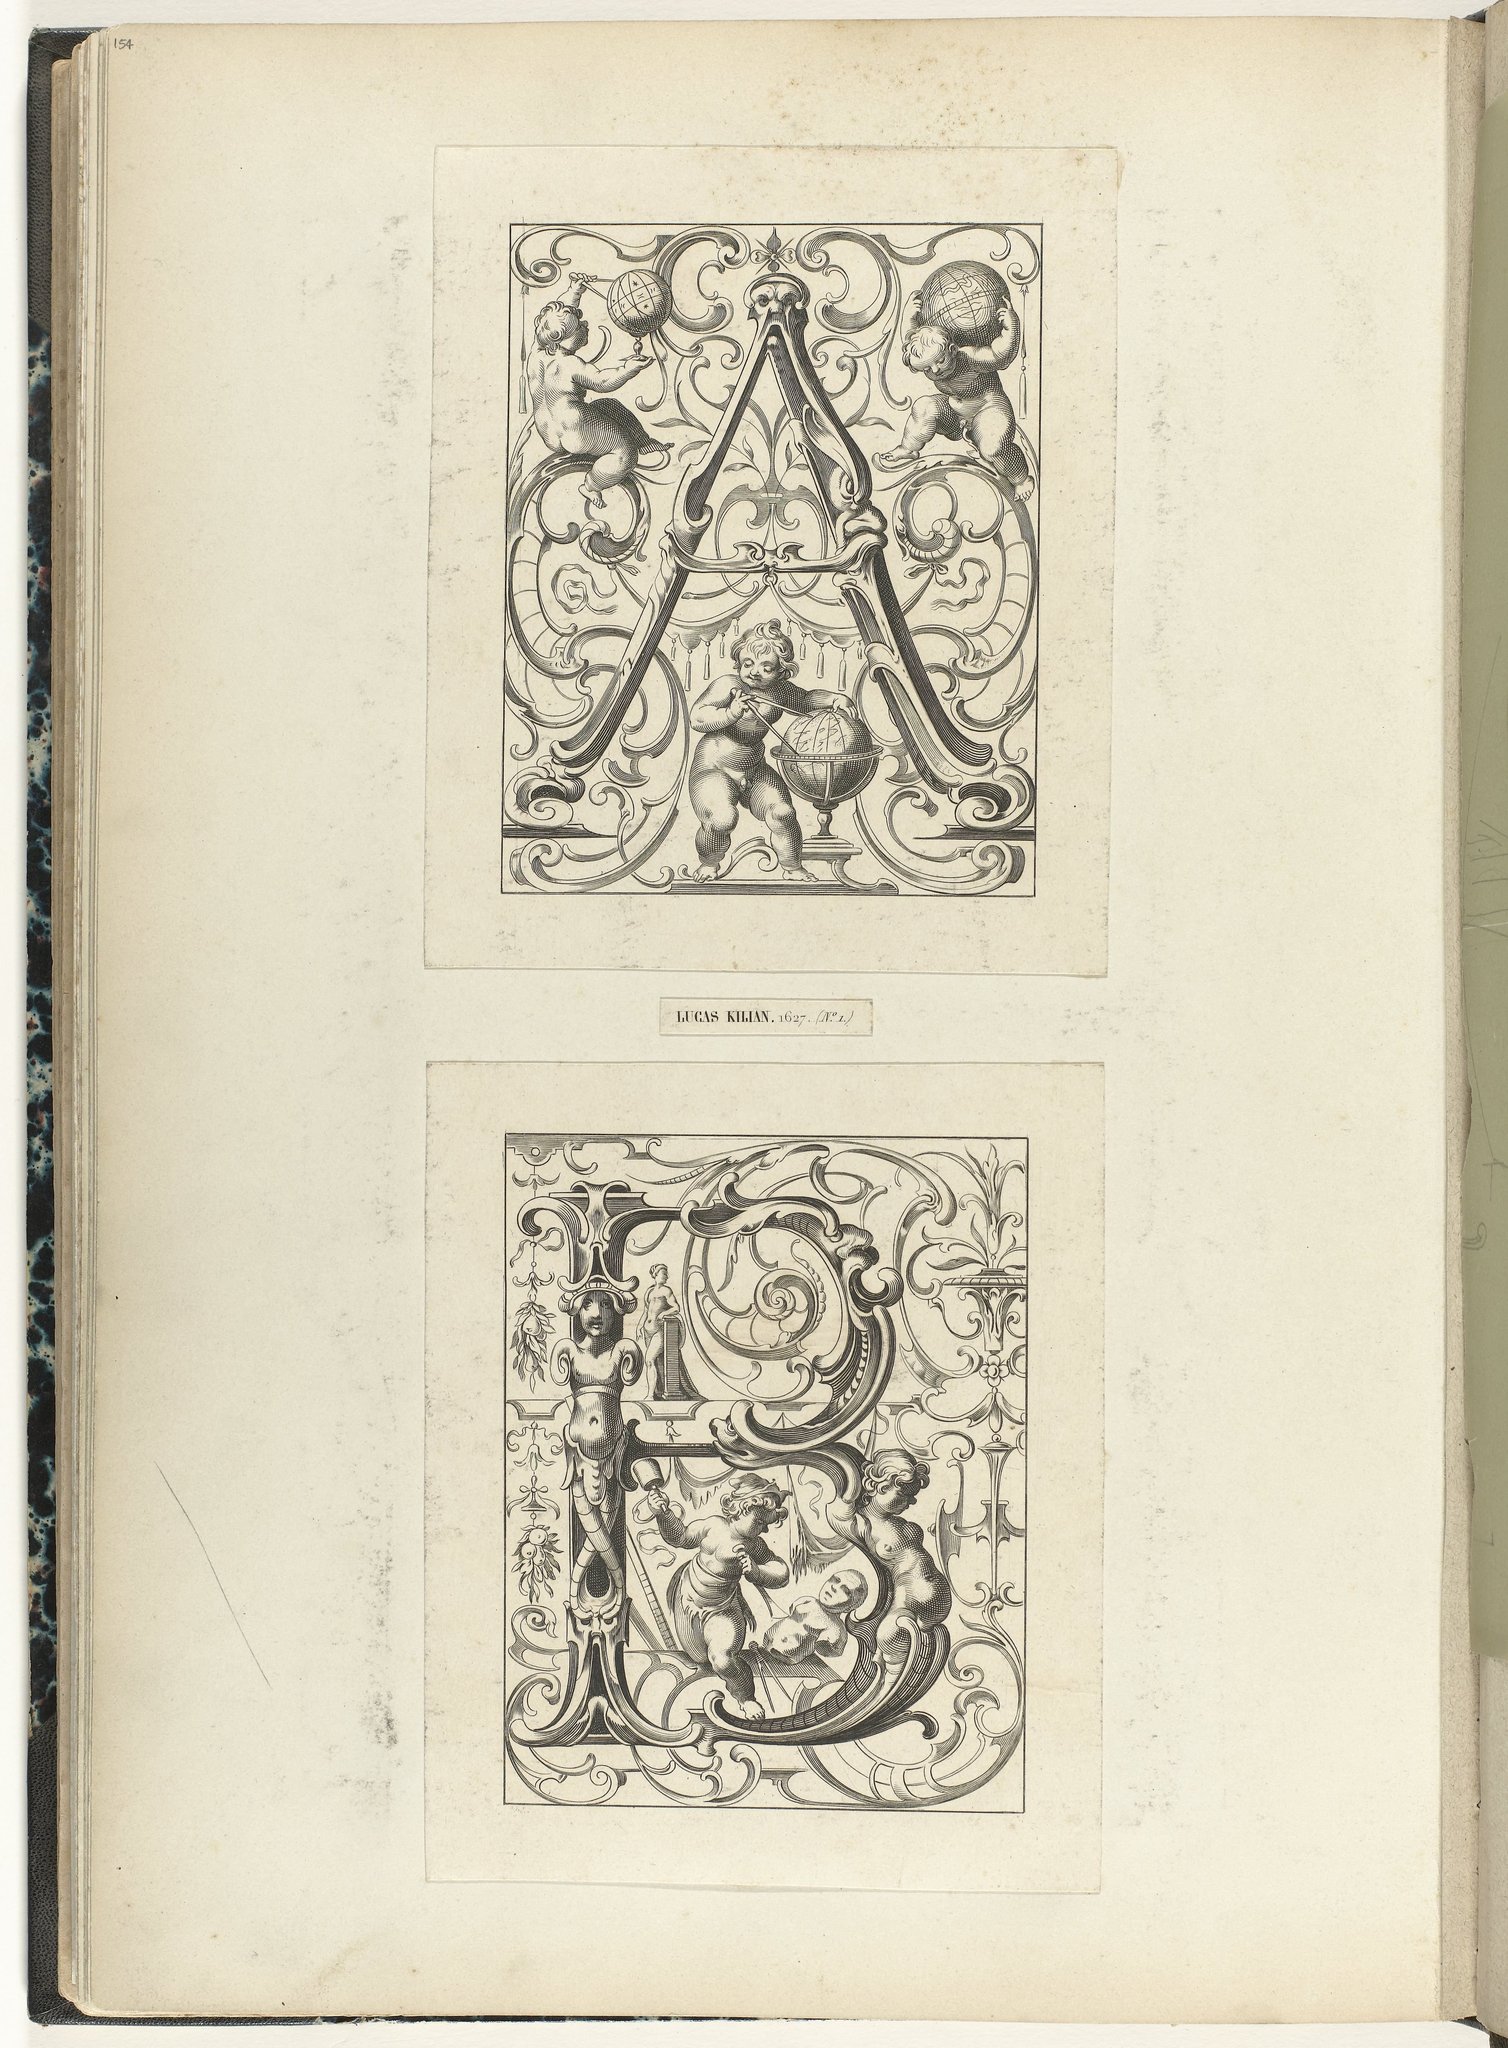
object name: print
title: Letter A en letter B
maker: Anonymous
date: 1627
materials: paper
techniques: engraving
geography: augsburg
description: Twee prenten met een letter. Letter A is opgebouwd uit maskers en omringd door drie putti en Schweifwerk. Letter B is opgebouwd uit maskers en bovenlichamen van vrouwen en omringd door Schweifwerk, onderin staat een putto.